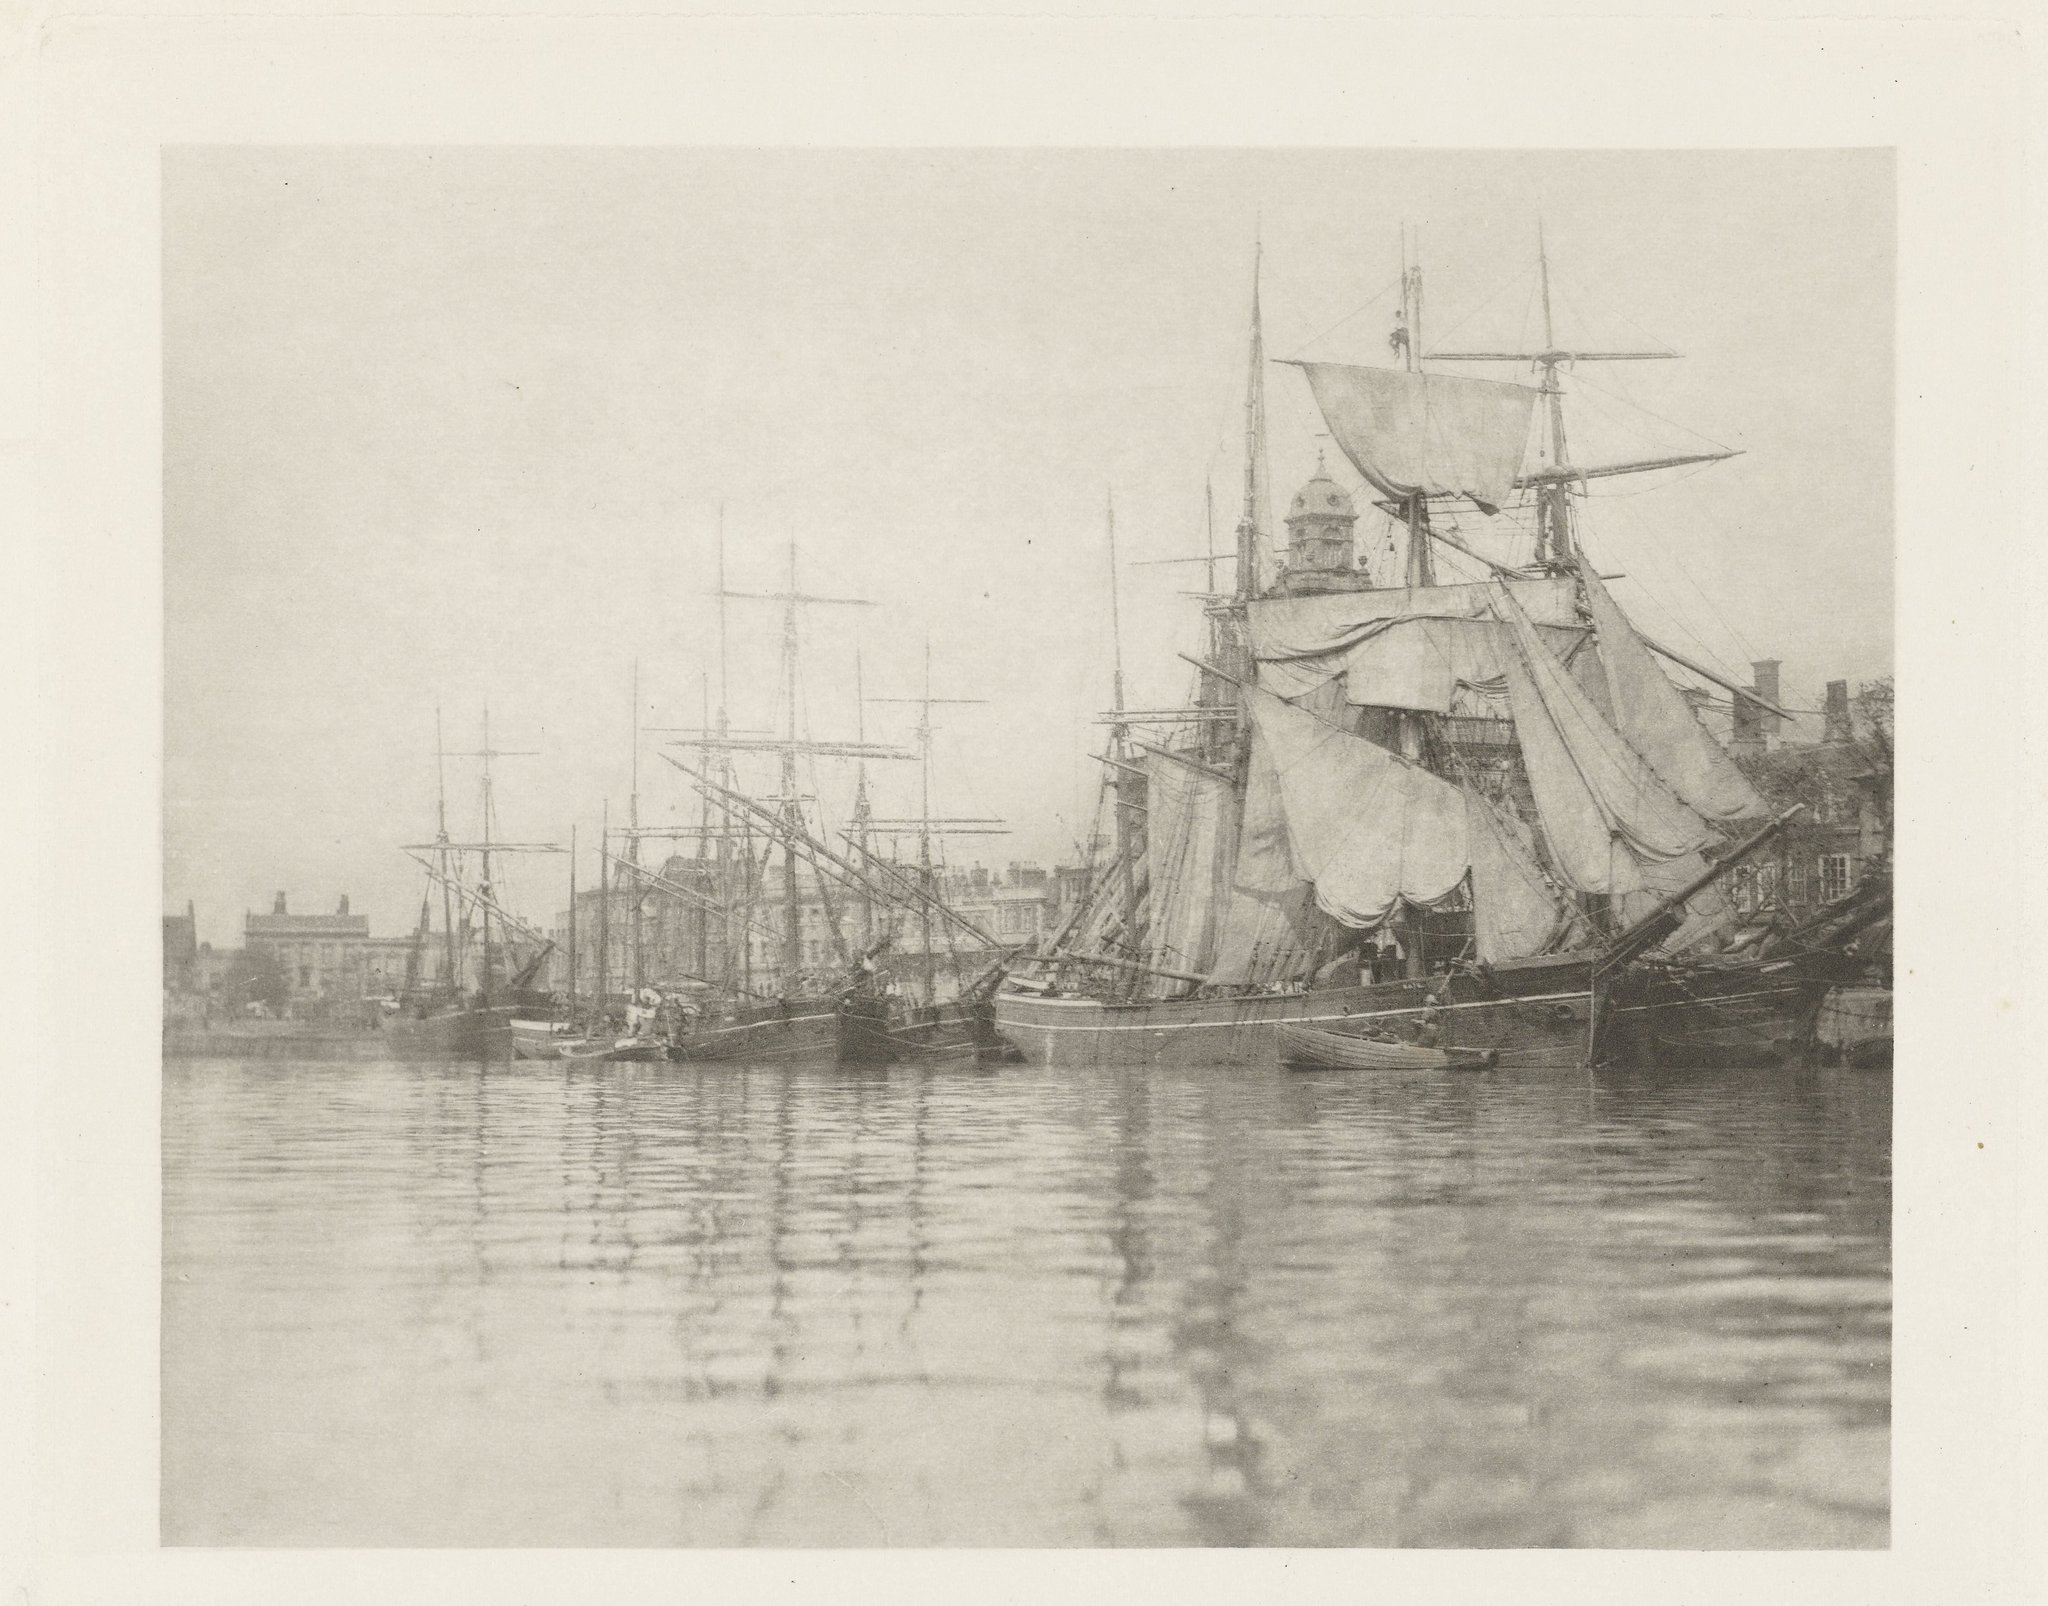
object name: photomechanical print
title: Schepen in de haven van Great Yarmouth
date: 1887-1890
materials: paper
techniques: photoaquatint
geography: london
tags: harbour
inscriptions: inscription: ‘PLATE I/ GREAT YARMOUTH HARBOUR/ Frontispiece’